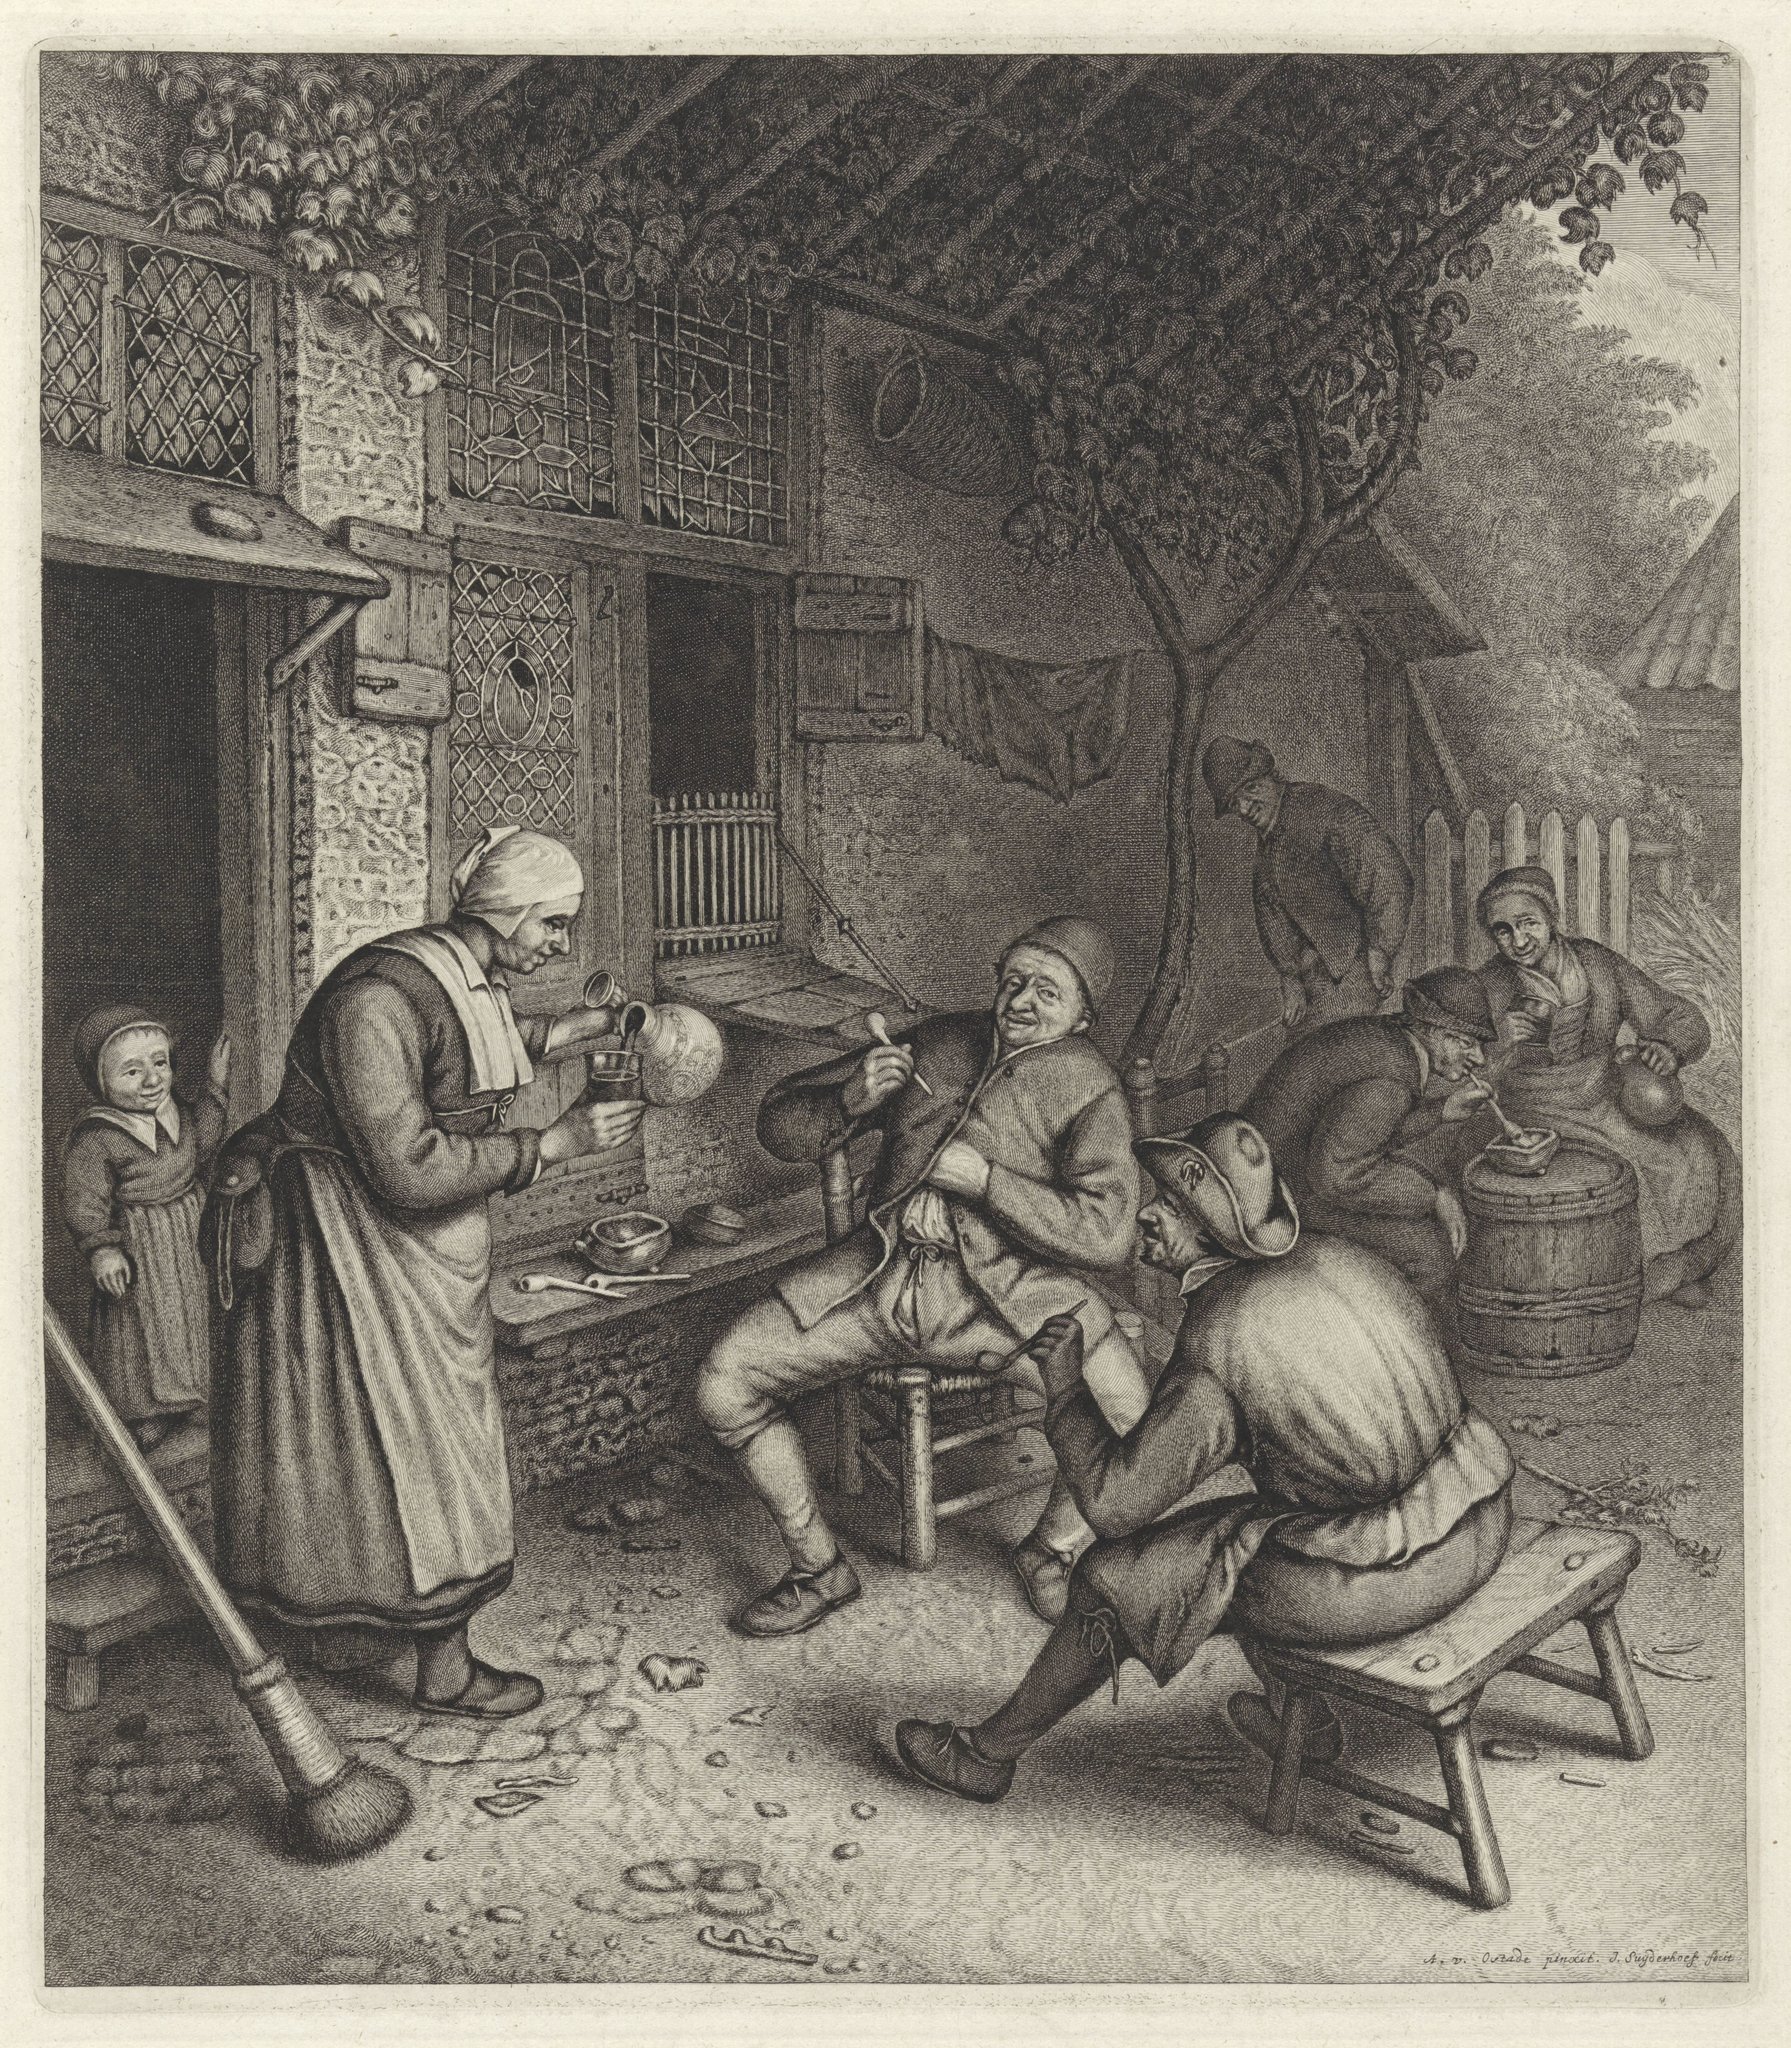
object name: print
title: Boeren op het terras voor een herberg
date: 1623-1686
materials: paper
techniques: engraving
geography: haarlem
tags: child, inn, coffee-house, public house, etc., pipe ~ tobacco, shrubs: broom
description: Voor een herberg zitten twee boeren, ieder met een pijp in de hand. Een vrouw schenkt een glas vol. In de deuropening een kind. Rechts een staande man en een man en een vrouw bij een ton.